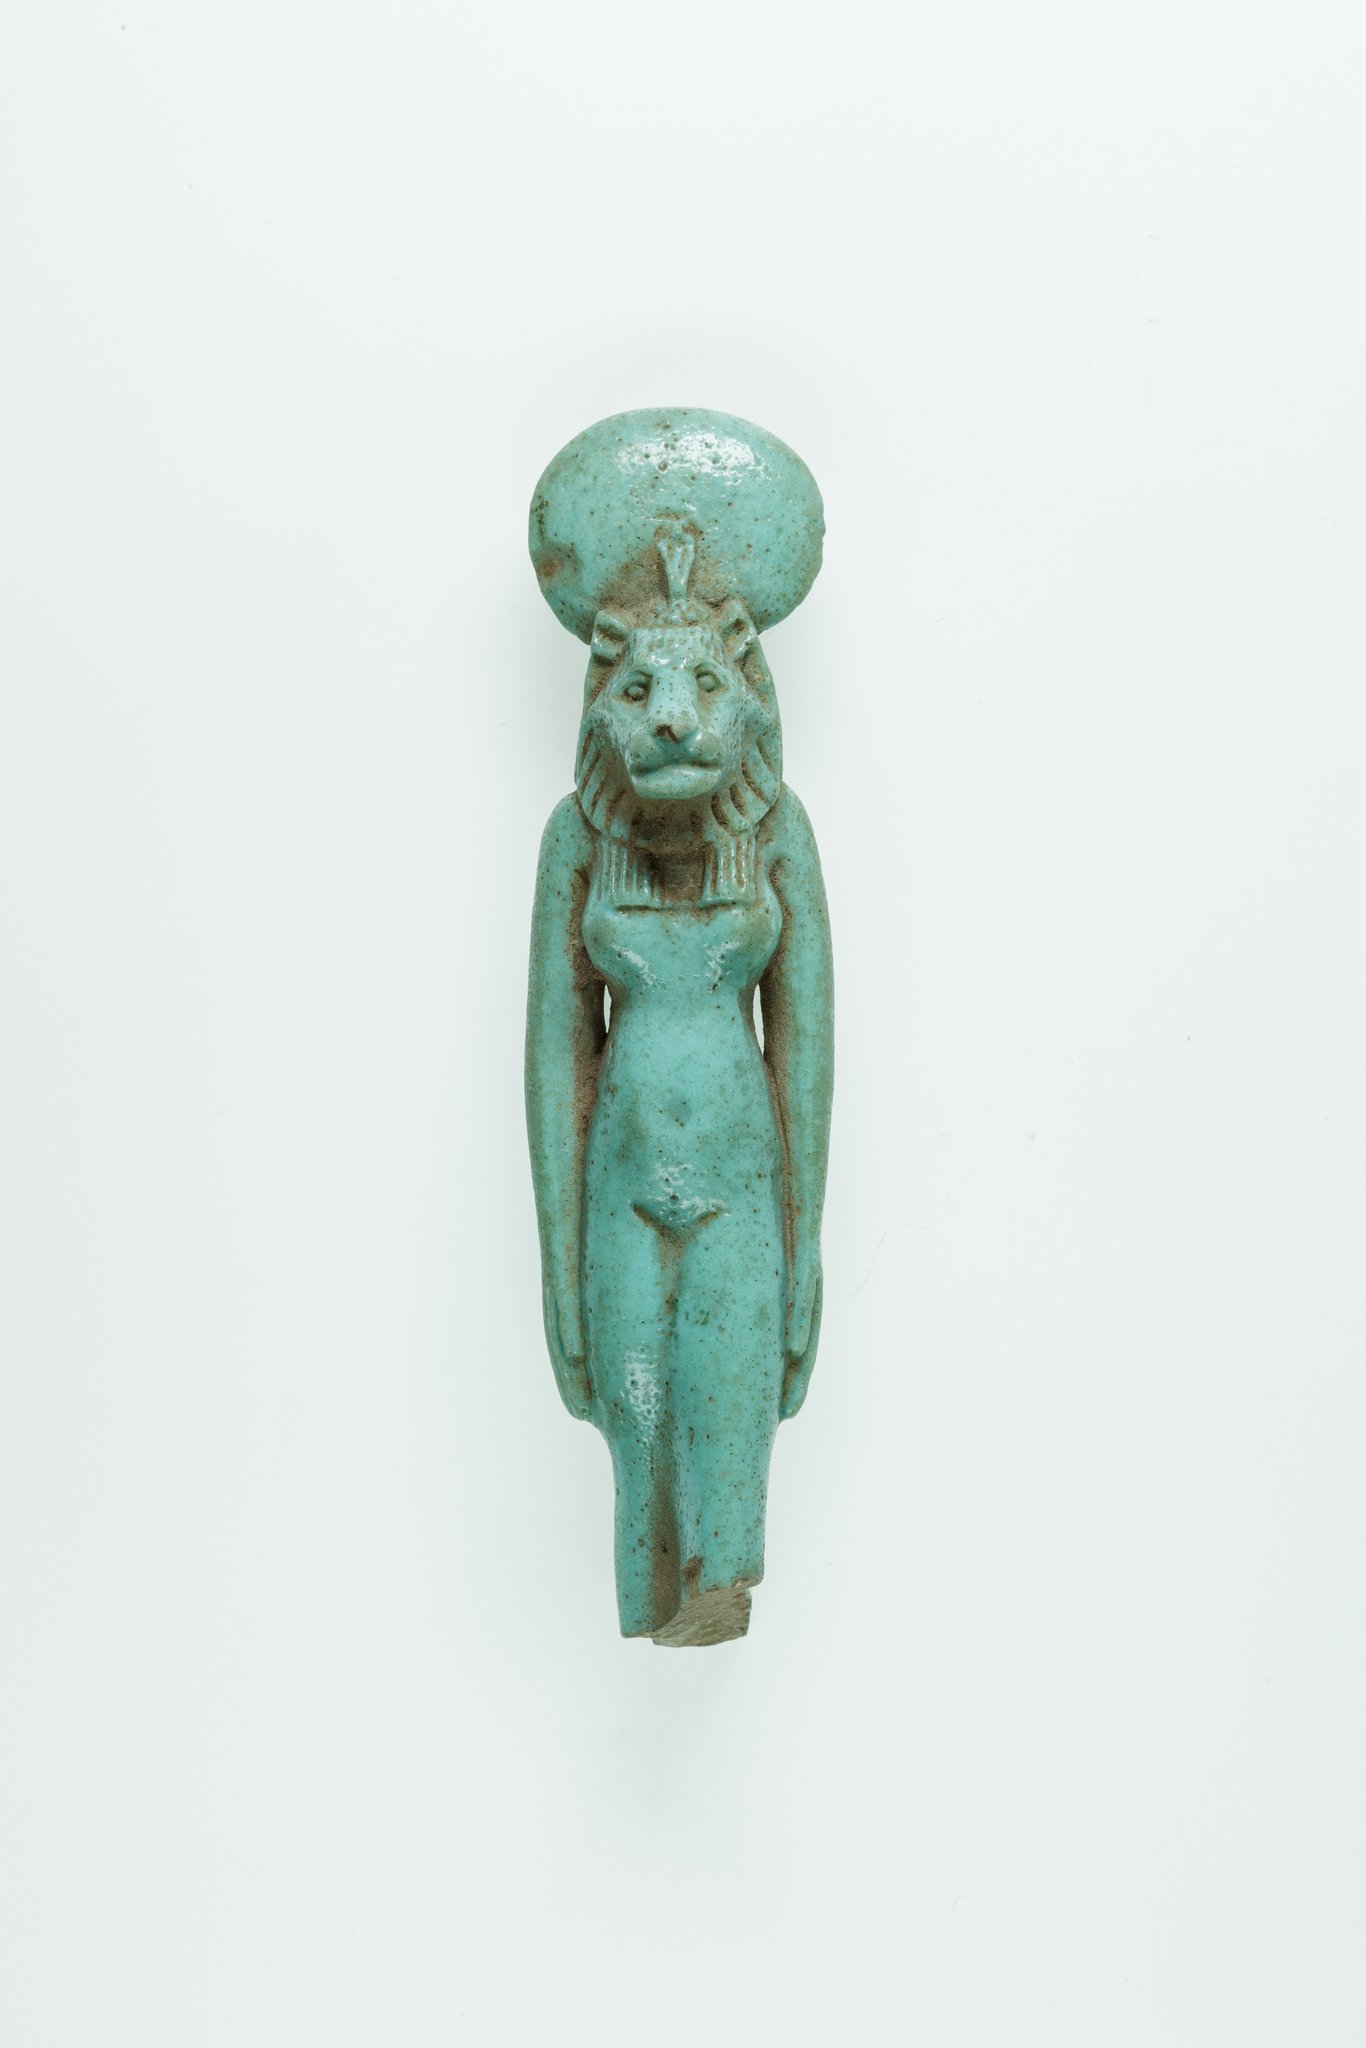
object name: statuette, amulet, lion headed, sakhment,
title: Statuette of a lion-headed goddess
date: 380-330 BCE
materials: faience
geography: egypt